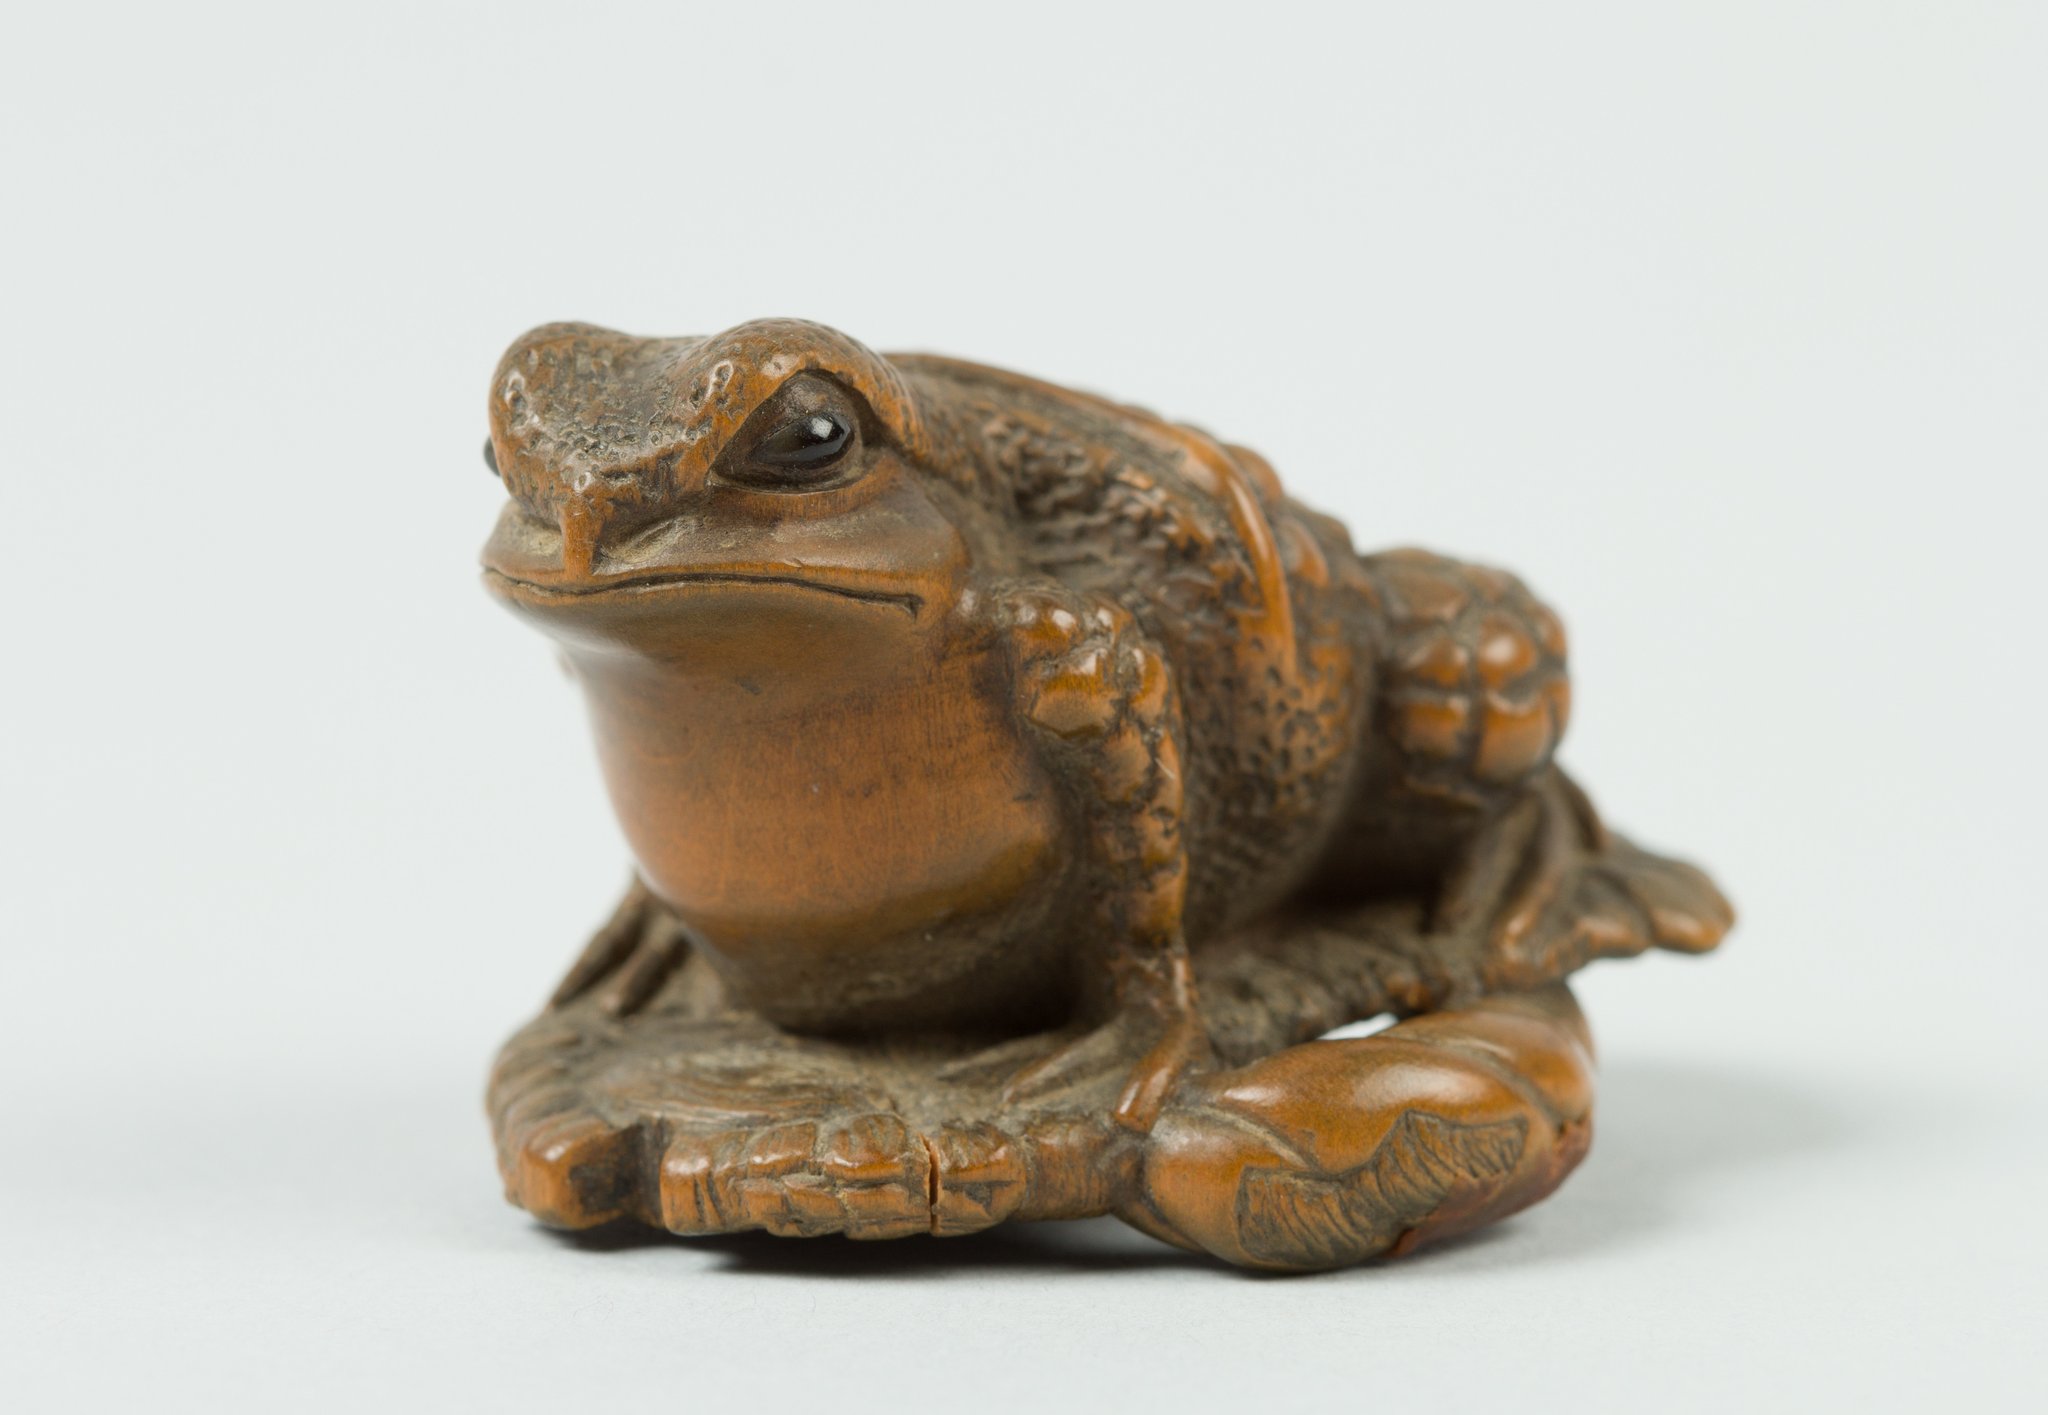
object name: netsuke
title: Netsuke of Toad on a Sandal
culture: japanese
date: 1801-1900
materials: wood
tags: frogs